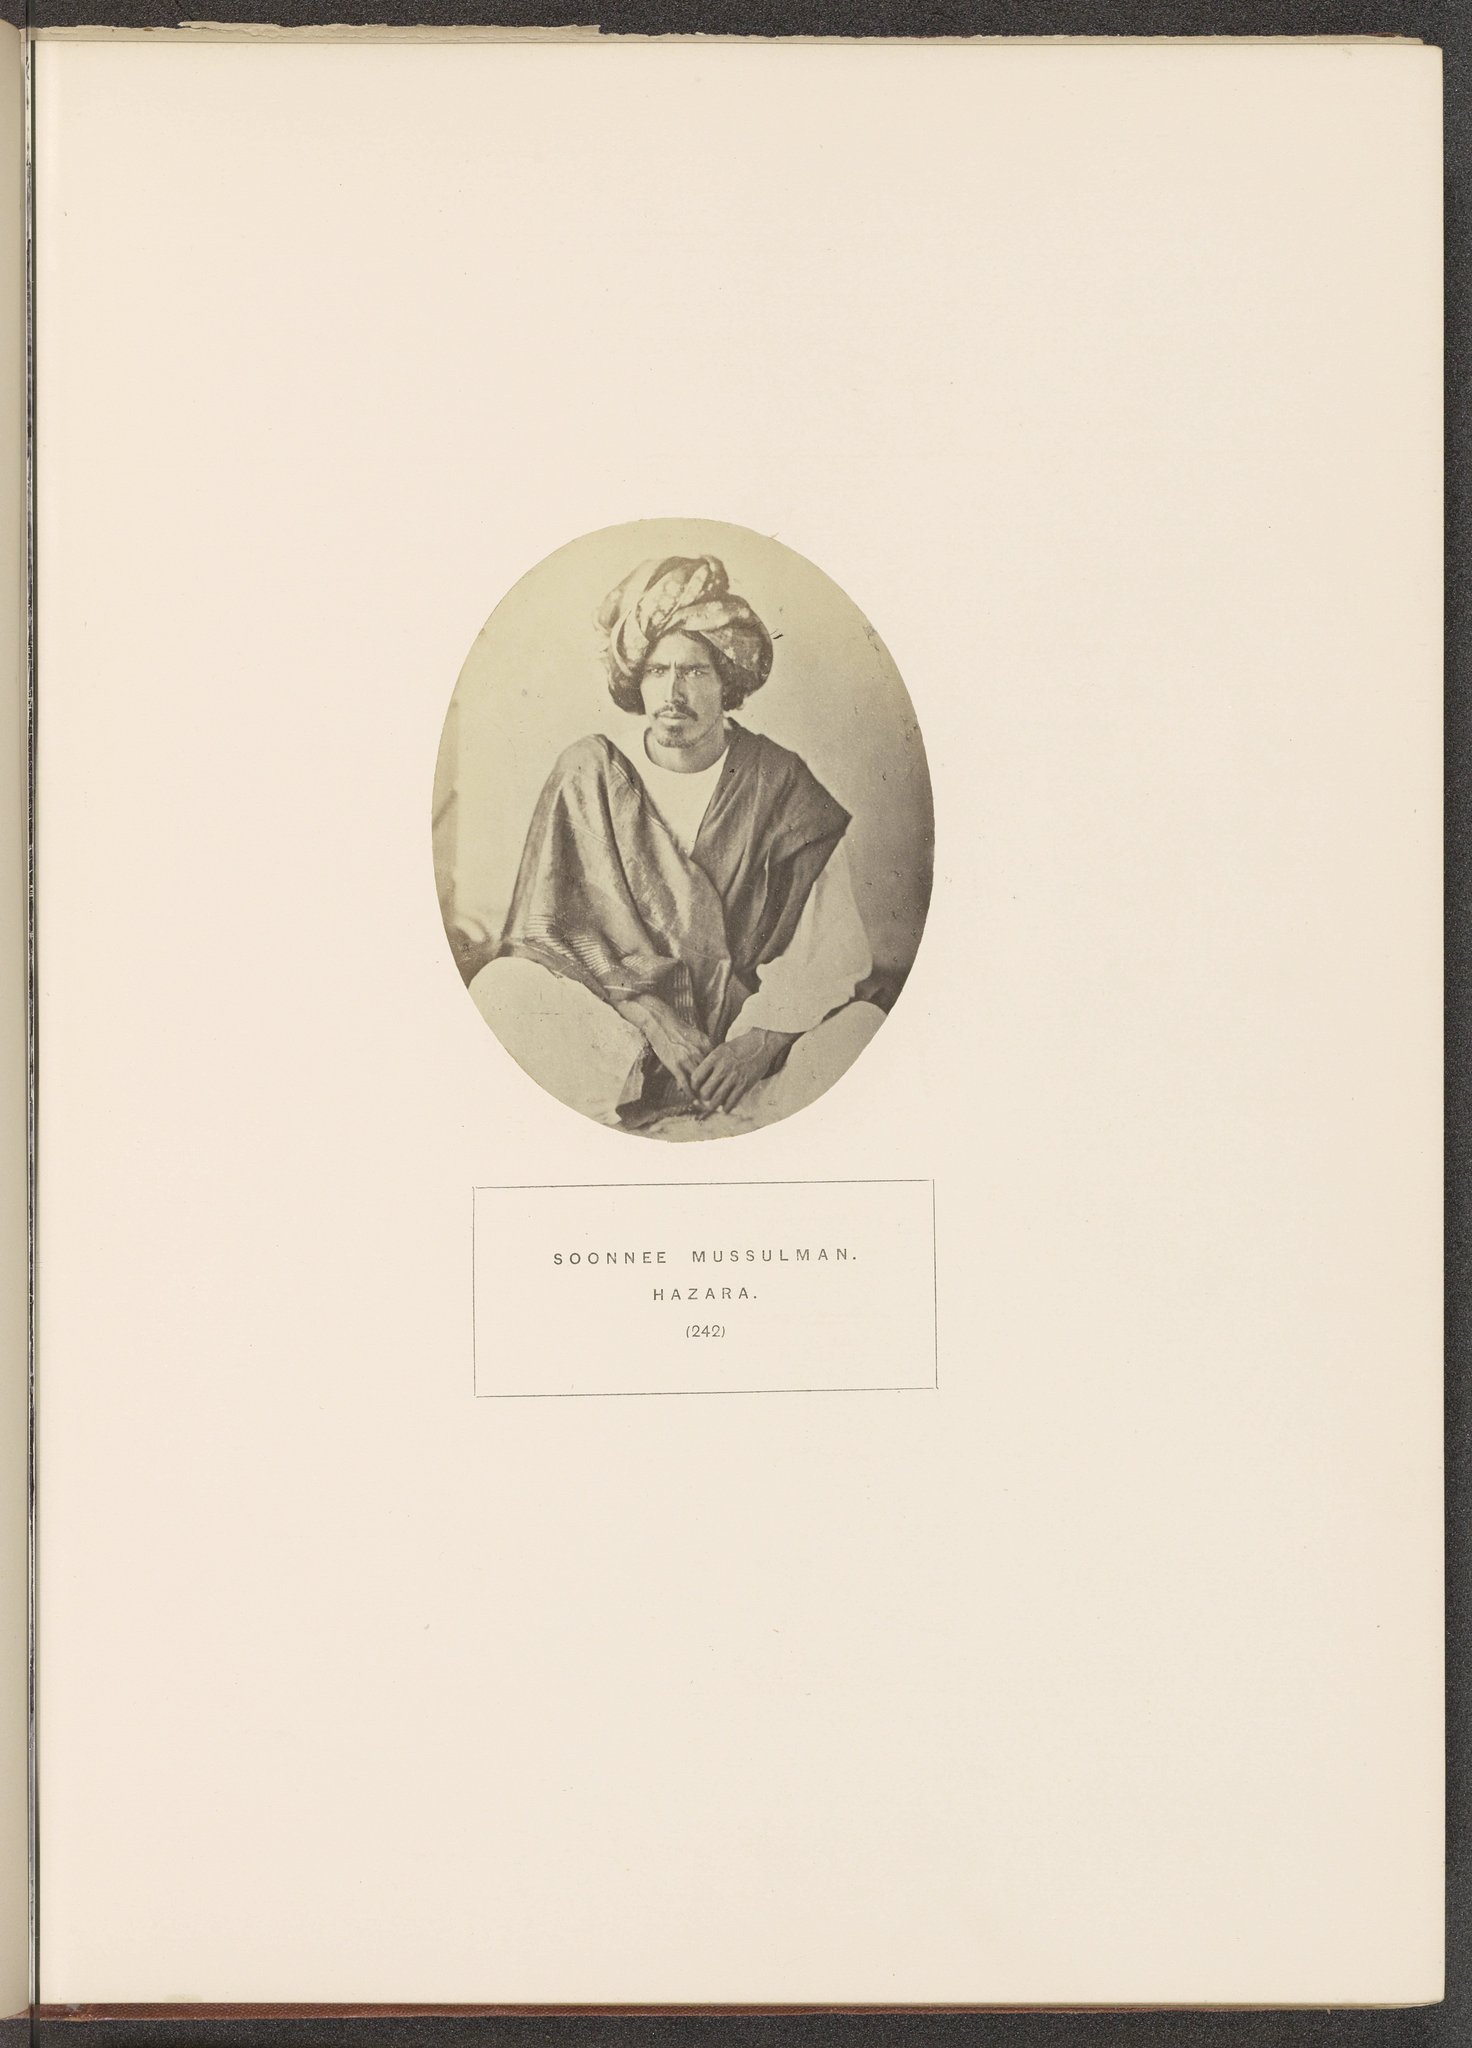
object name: photograph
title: Portrait of an unknown man with a turban from the Yusufzai Pathan tribe of Hazara, Khyber Pakhtunkhwa, Pakistan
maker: Anonymous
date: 1862-1872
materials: photographic support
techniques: albumen print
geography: hazara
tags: head-gear: turban, human races; peoples; nationalities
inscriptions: number: ‘(242)’, inscription: ‘SOONNEE MUSSULMAN./ HAZARA.’